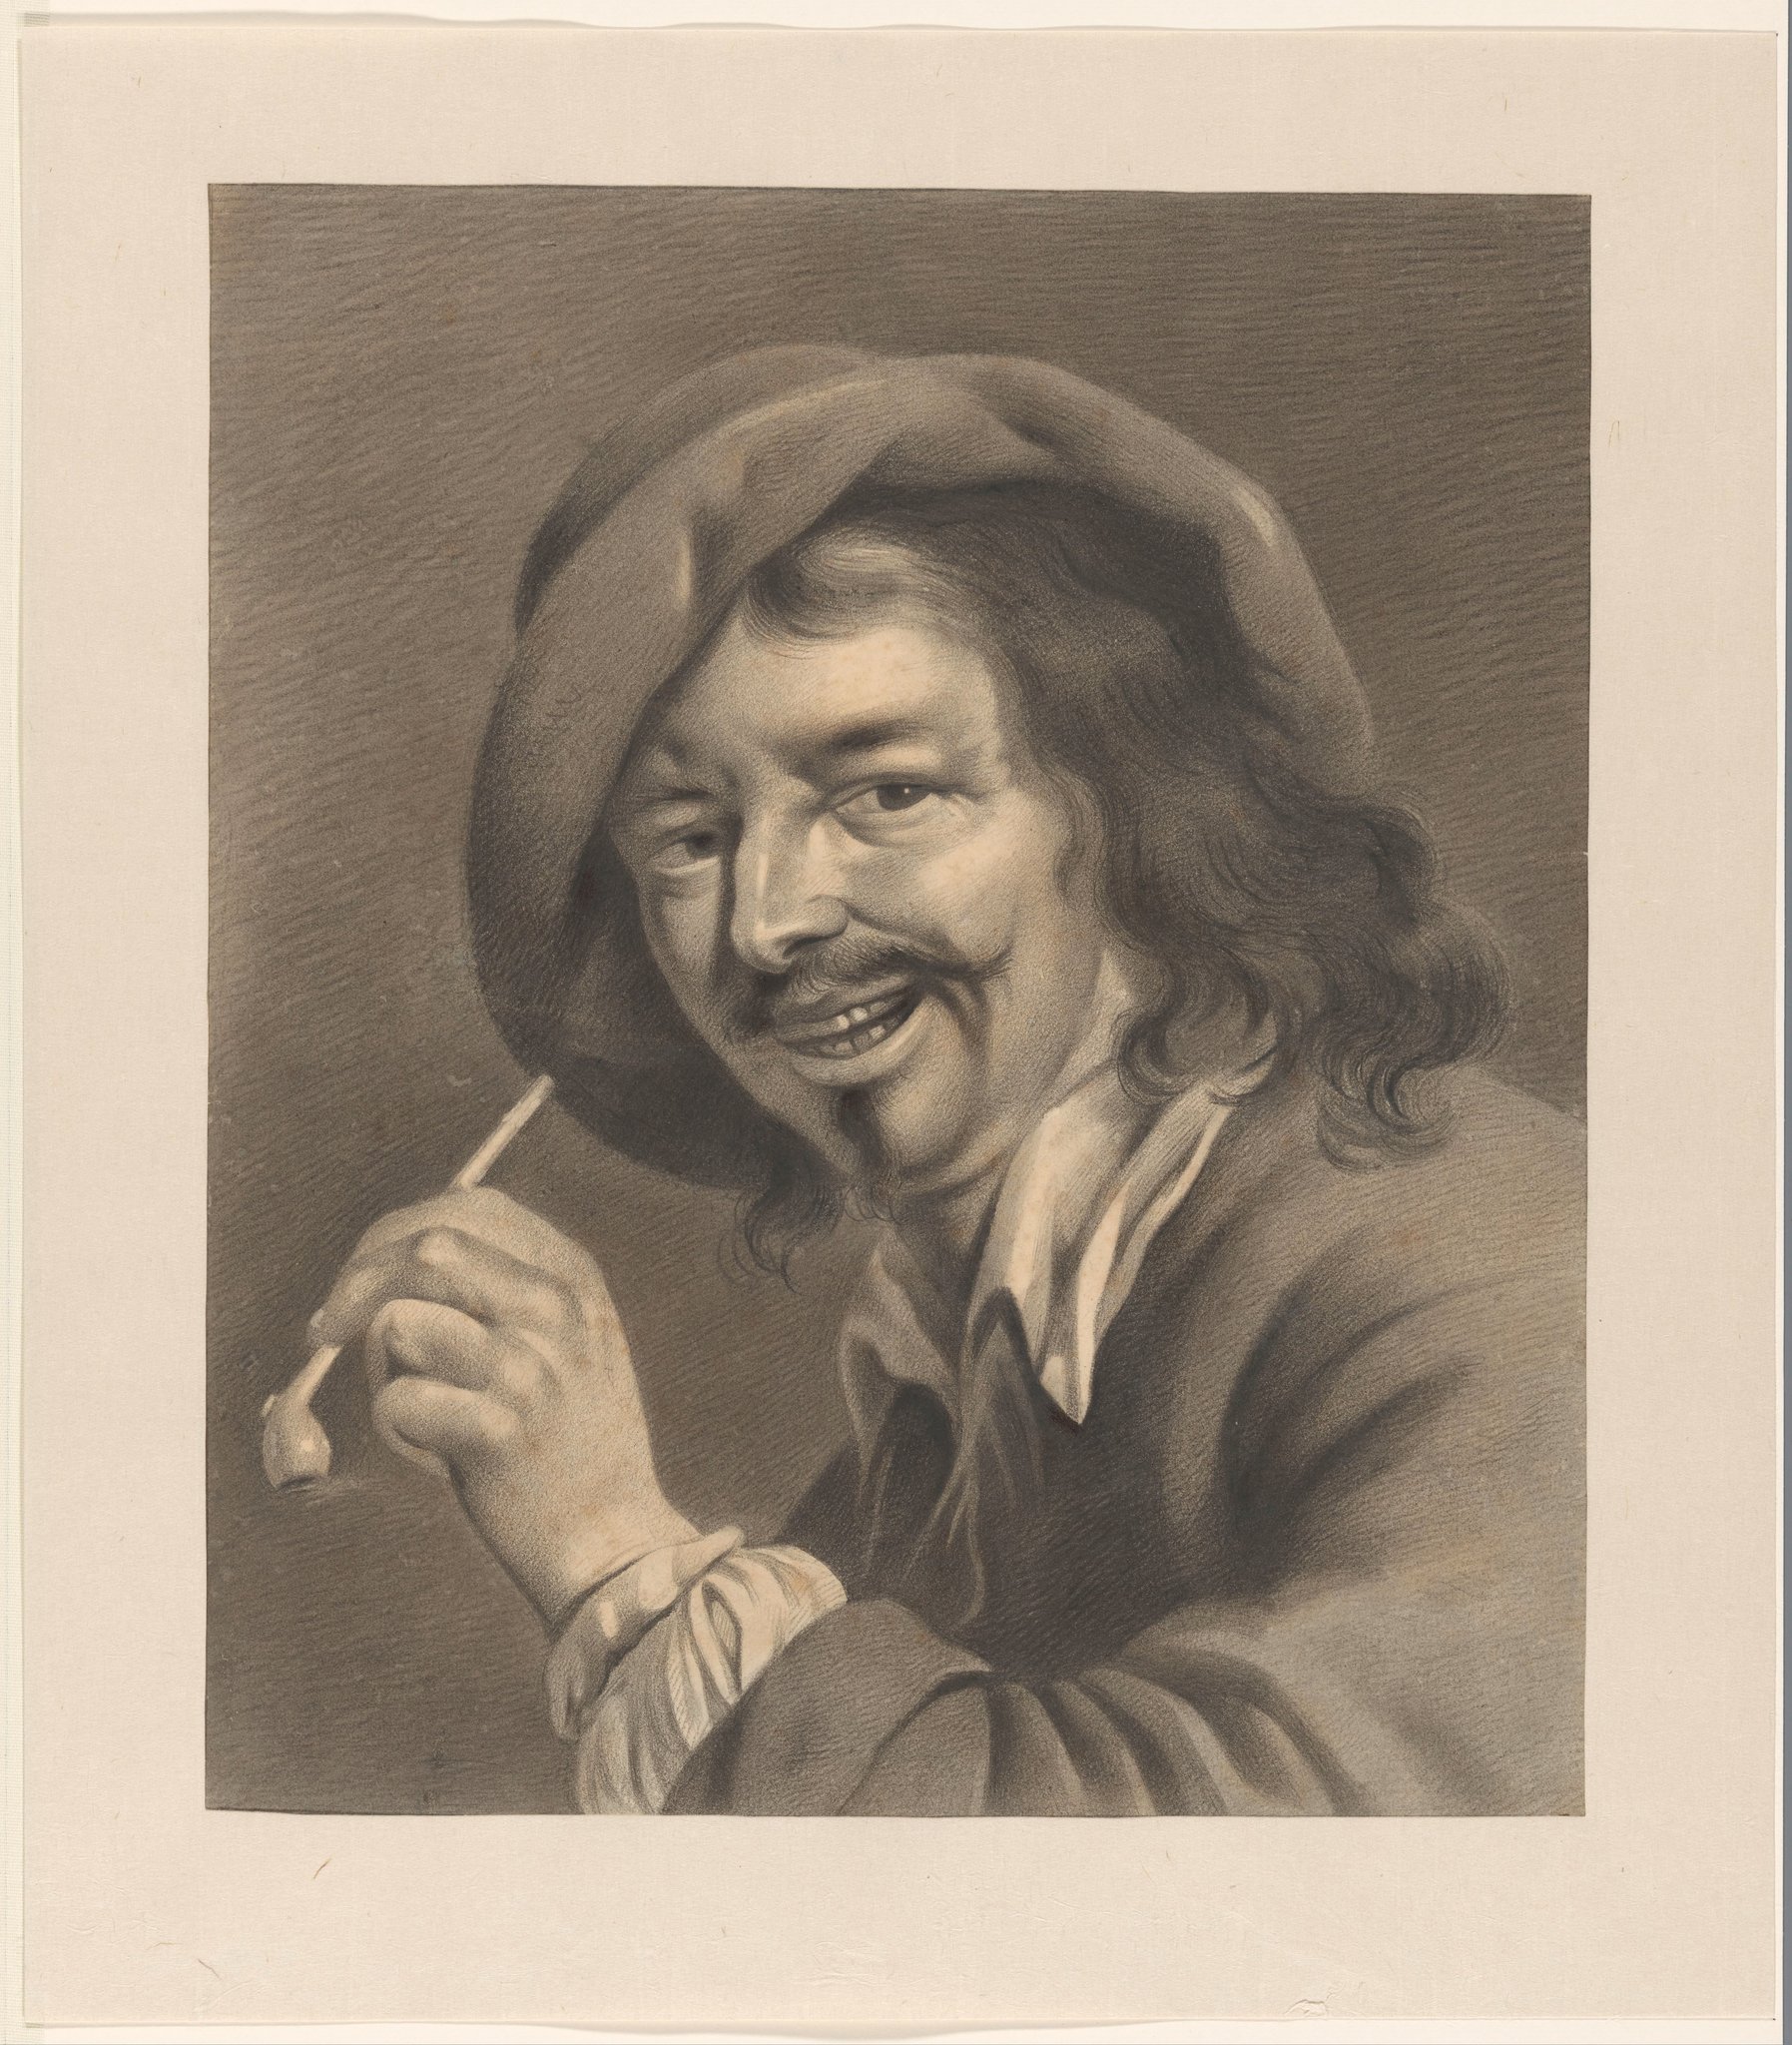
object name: drawing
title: Zintuig Reuk: lachende pijproker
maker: jan adriaan antonie de lelie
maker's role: draughtsman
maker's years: 1788-1845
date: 1798-1845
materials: chalk, paper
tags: smell, smelling (one of the five senses), pipe ~ tobacco (+ taking (particular) foodstuffs: eating, drinking, smoking, chewing, etc.)